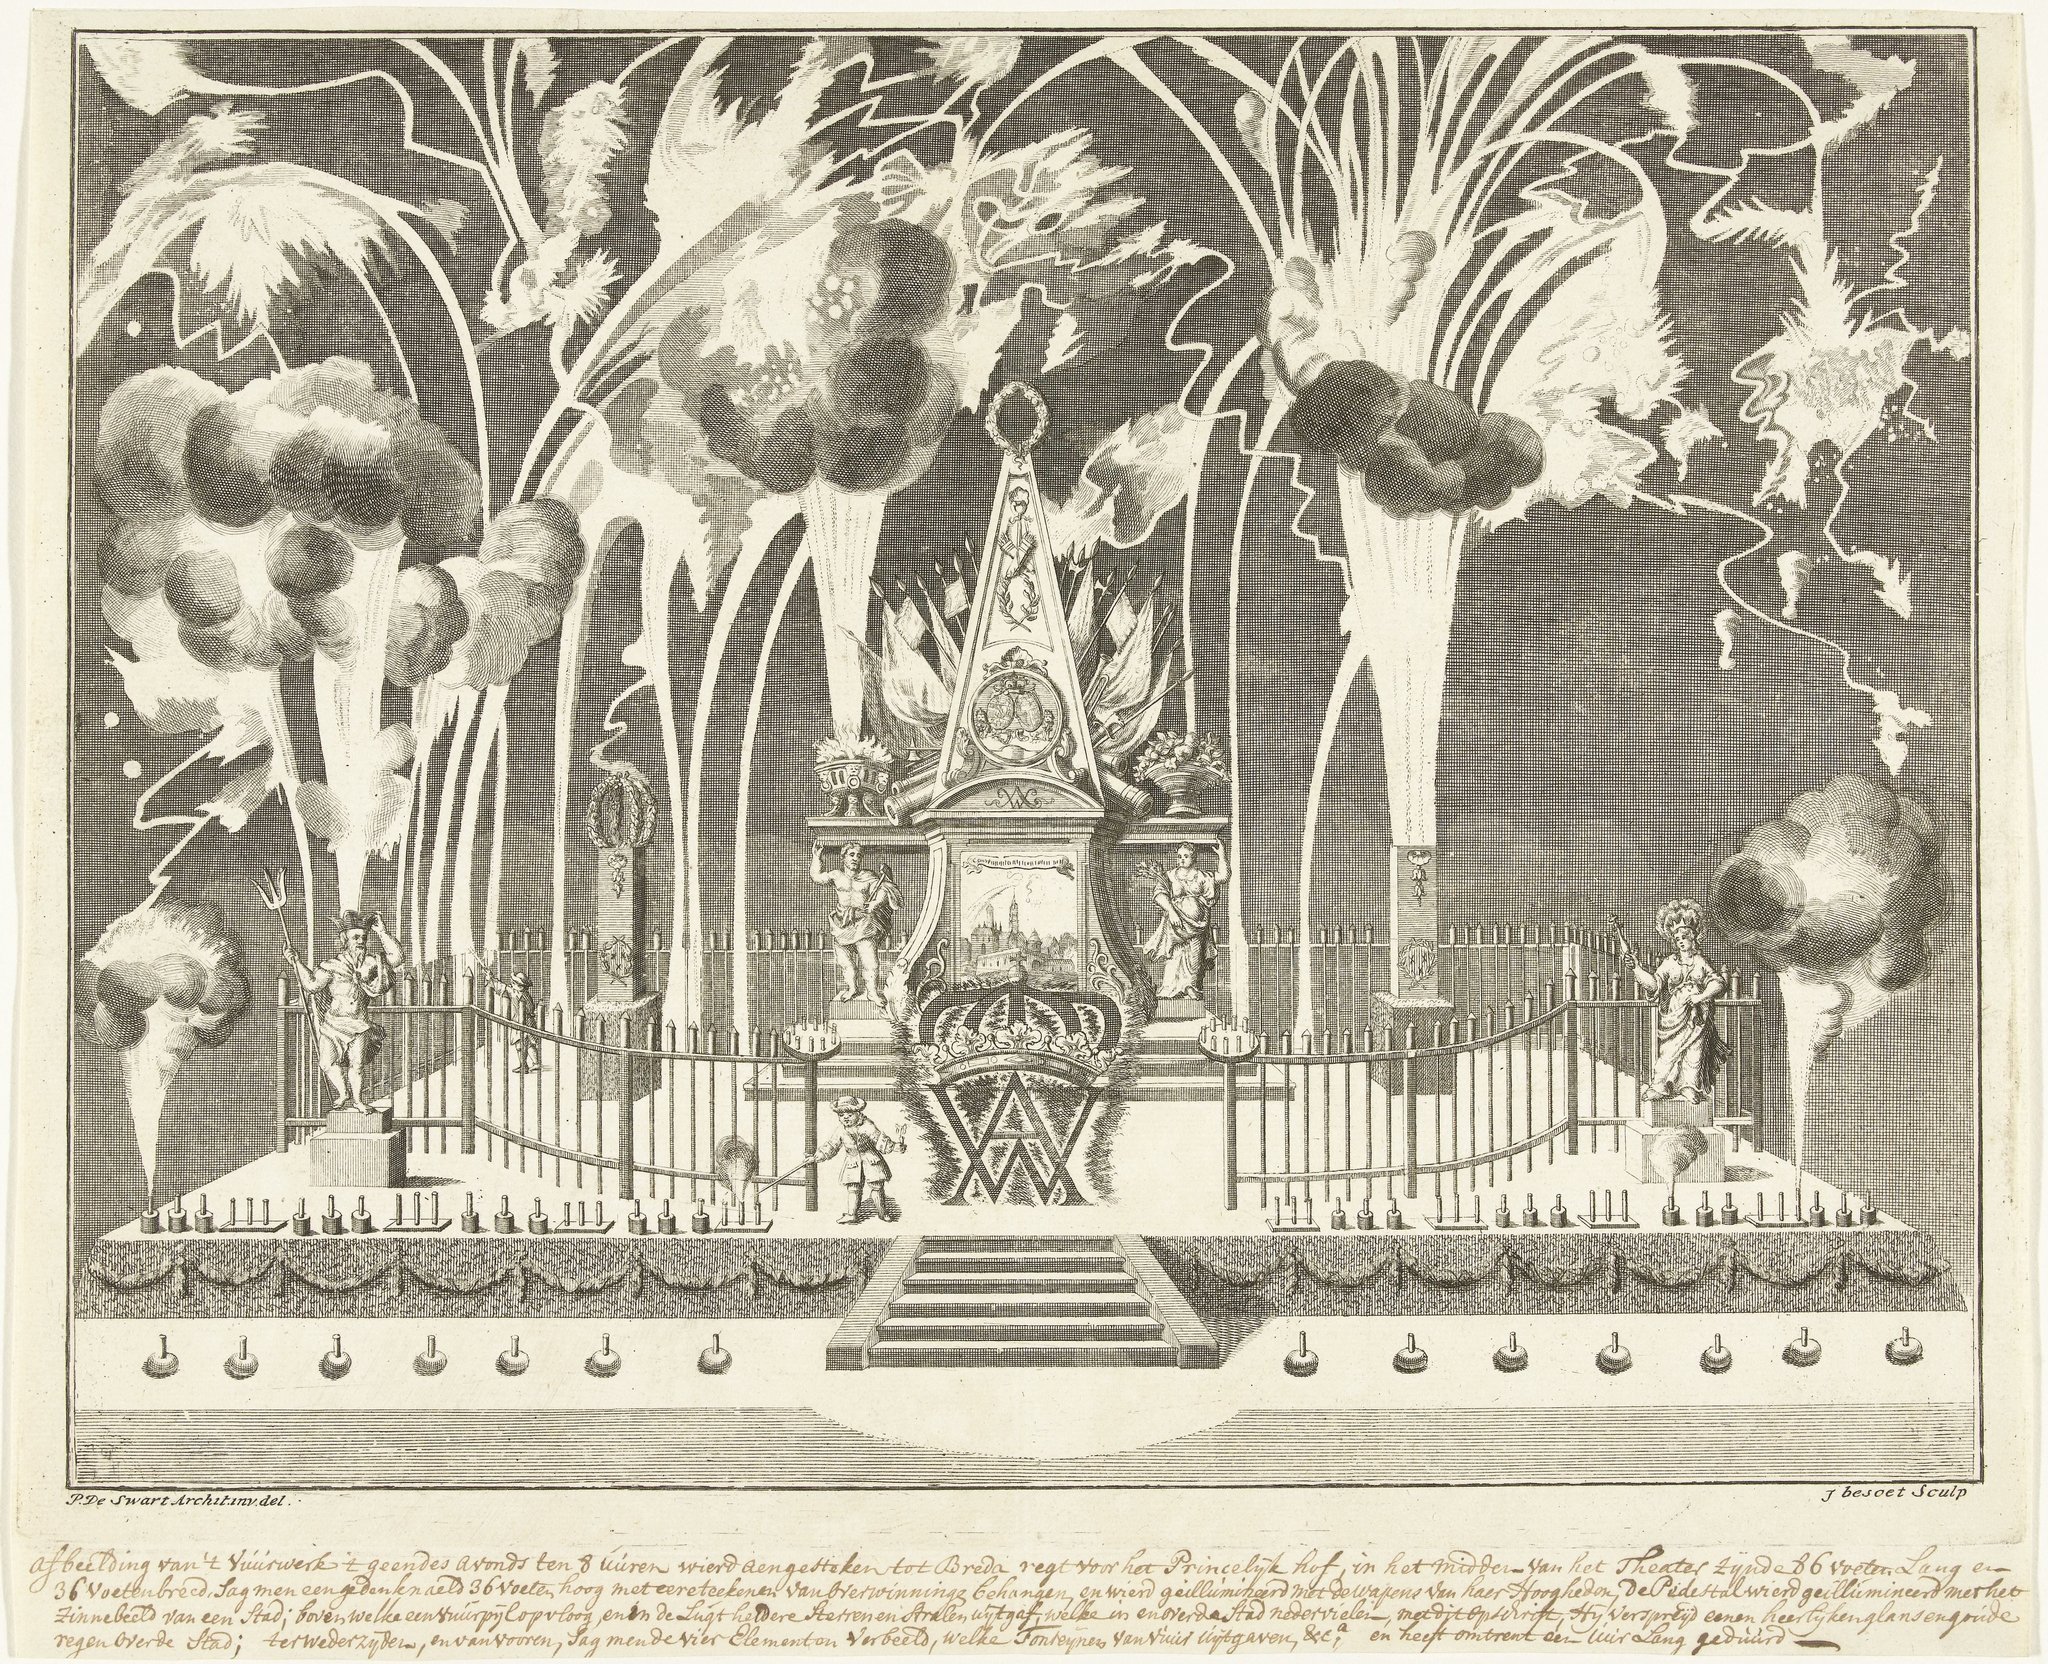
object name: print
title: Vuurwerk bij de intrede van Willem IV te Breda, 1737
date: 1737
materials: paper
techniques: etching, writing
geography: northern netherlands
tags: willem iv (prins van oranje-nassau), anna van hannover, bonfire, fire-works (+ illumination, fire-works ~ festive activities)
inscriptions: collector's mark: Lugt 2228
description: Gebruikt als illustratie in: Het blyde Breda ofte korte verhaal van de plegtige intrede van ... Willem Carel Hendrik Friso ... als Heer en Baron van Breda : ende H.K. Hoogheid Anna ... geschied op den XIII. van herfstmaand, 1737. 's-Gravenhage en Breda: Jacobus van den Kieboom & Johannnes van den Kieboom, 1737.